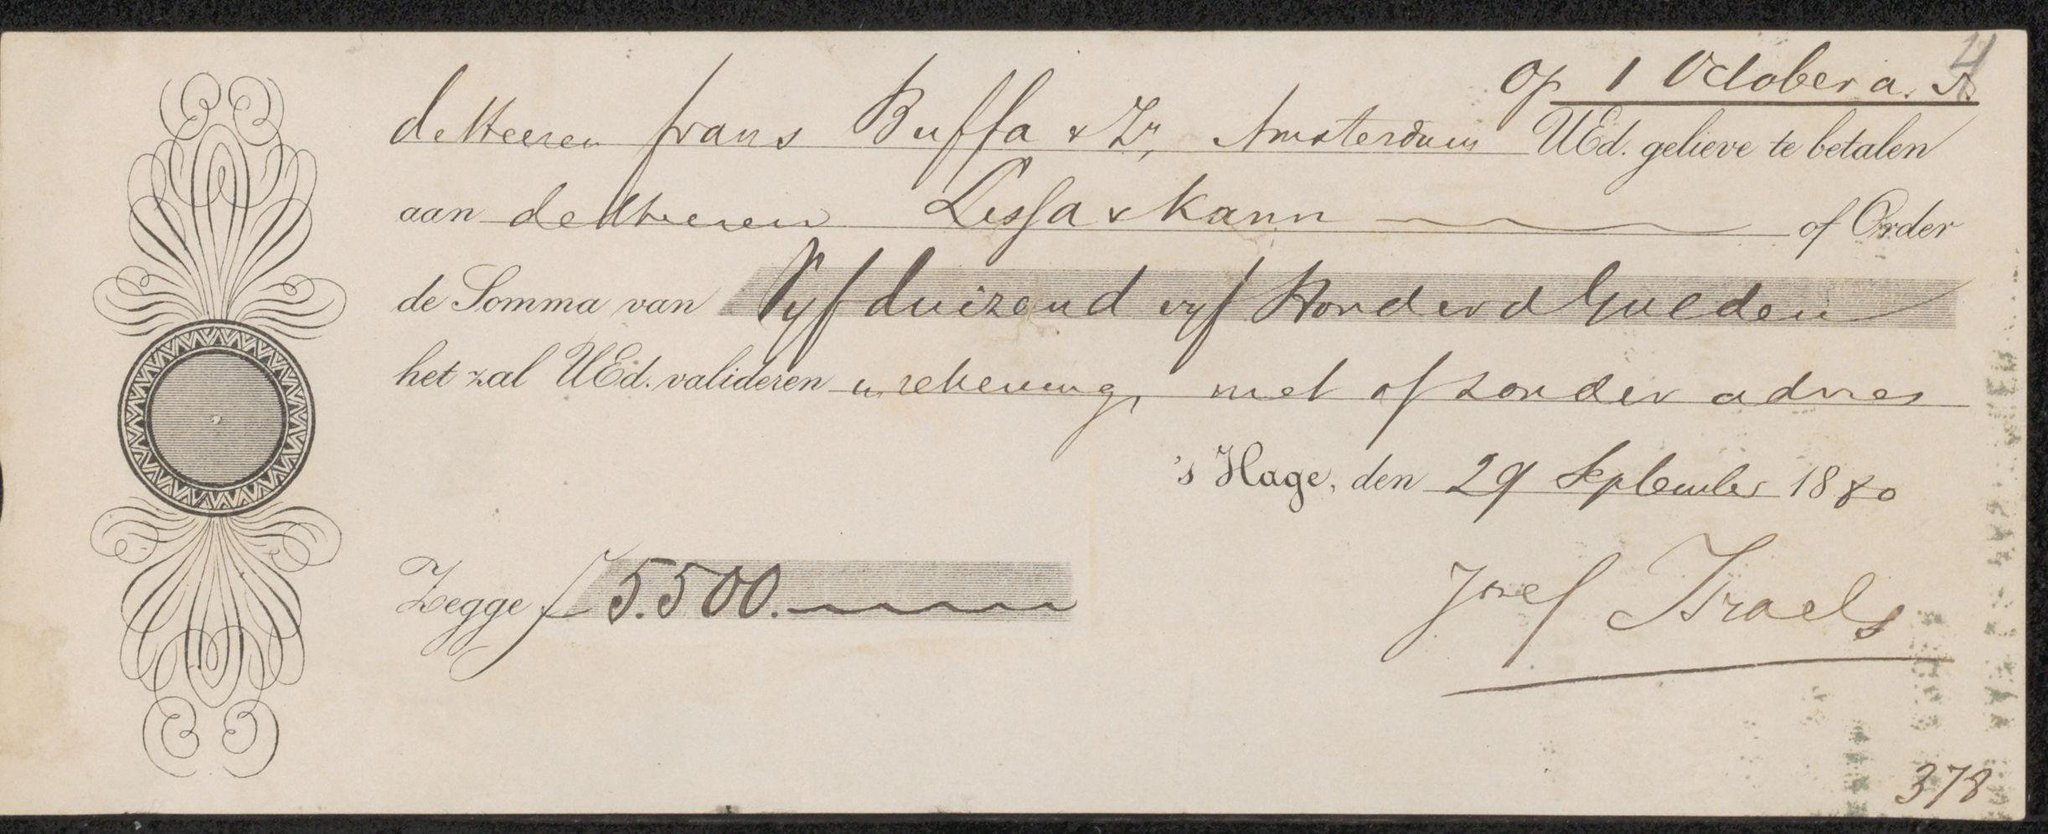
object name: ontvangstbewijs, kwitantie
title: Kwitantie voor Frans Buffa en Zonen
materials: ink, paper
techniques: pen, printing, writing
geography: the hague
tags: money, amsterdam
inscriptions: collector's mark: Lugt 2233